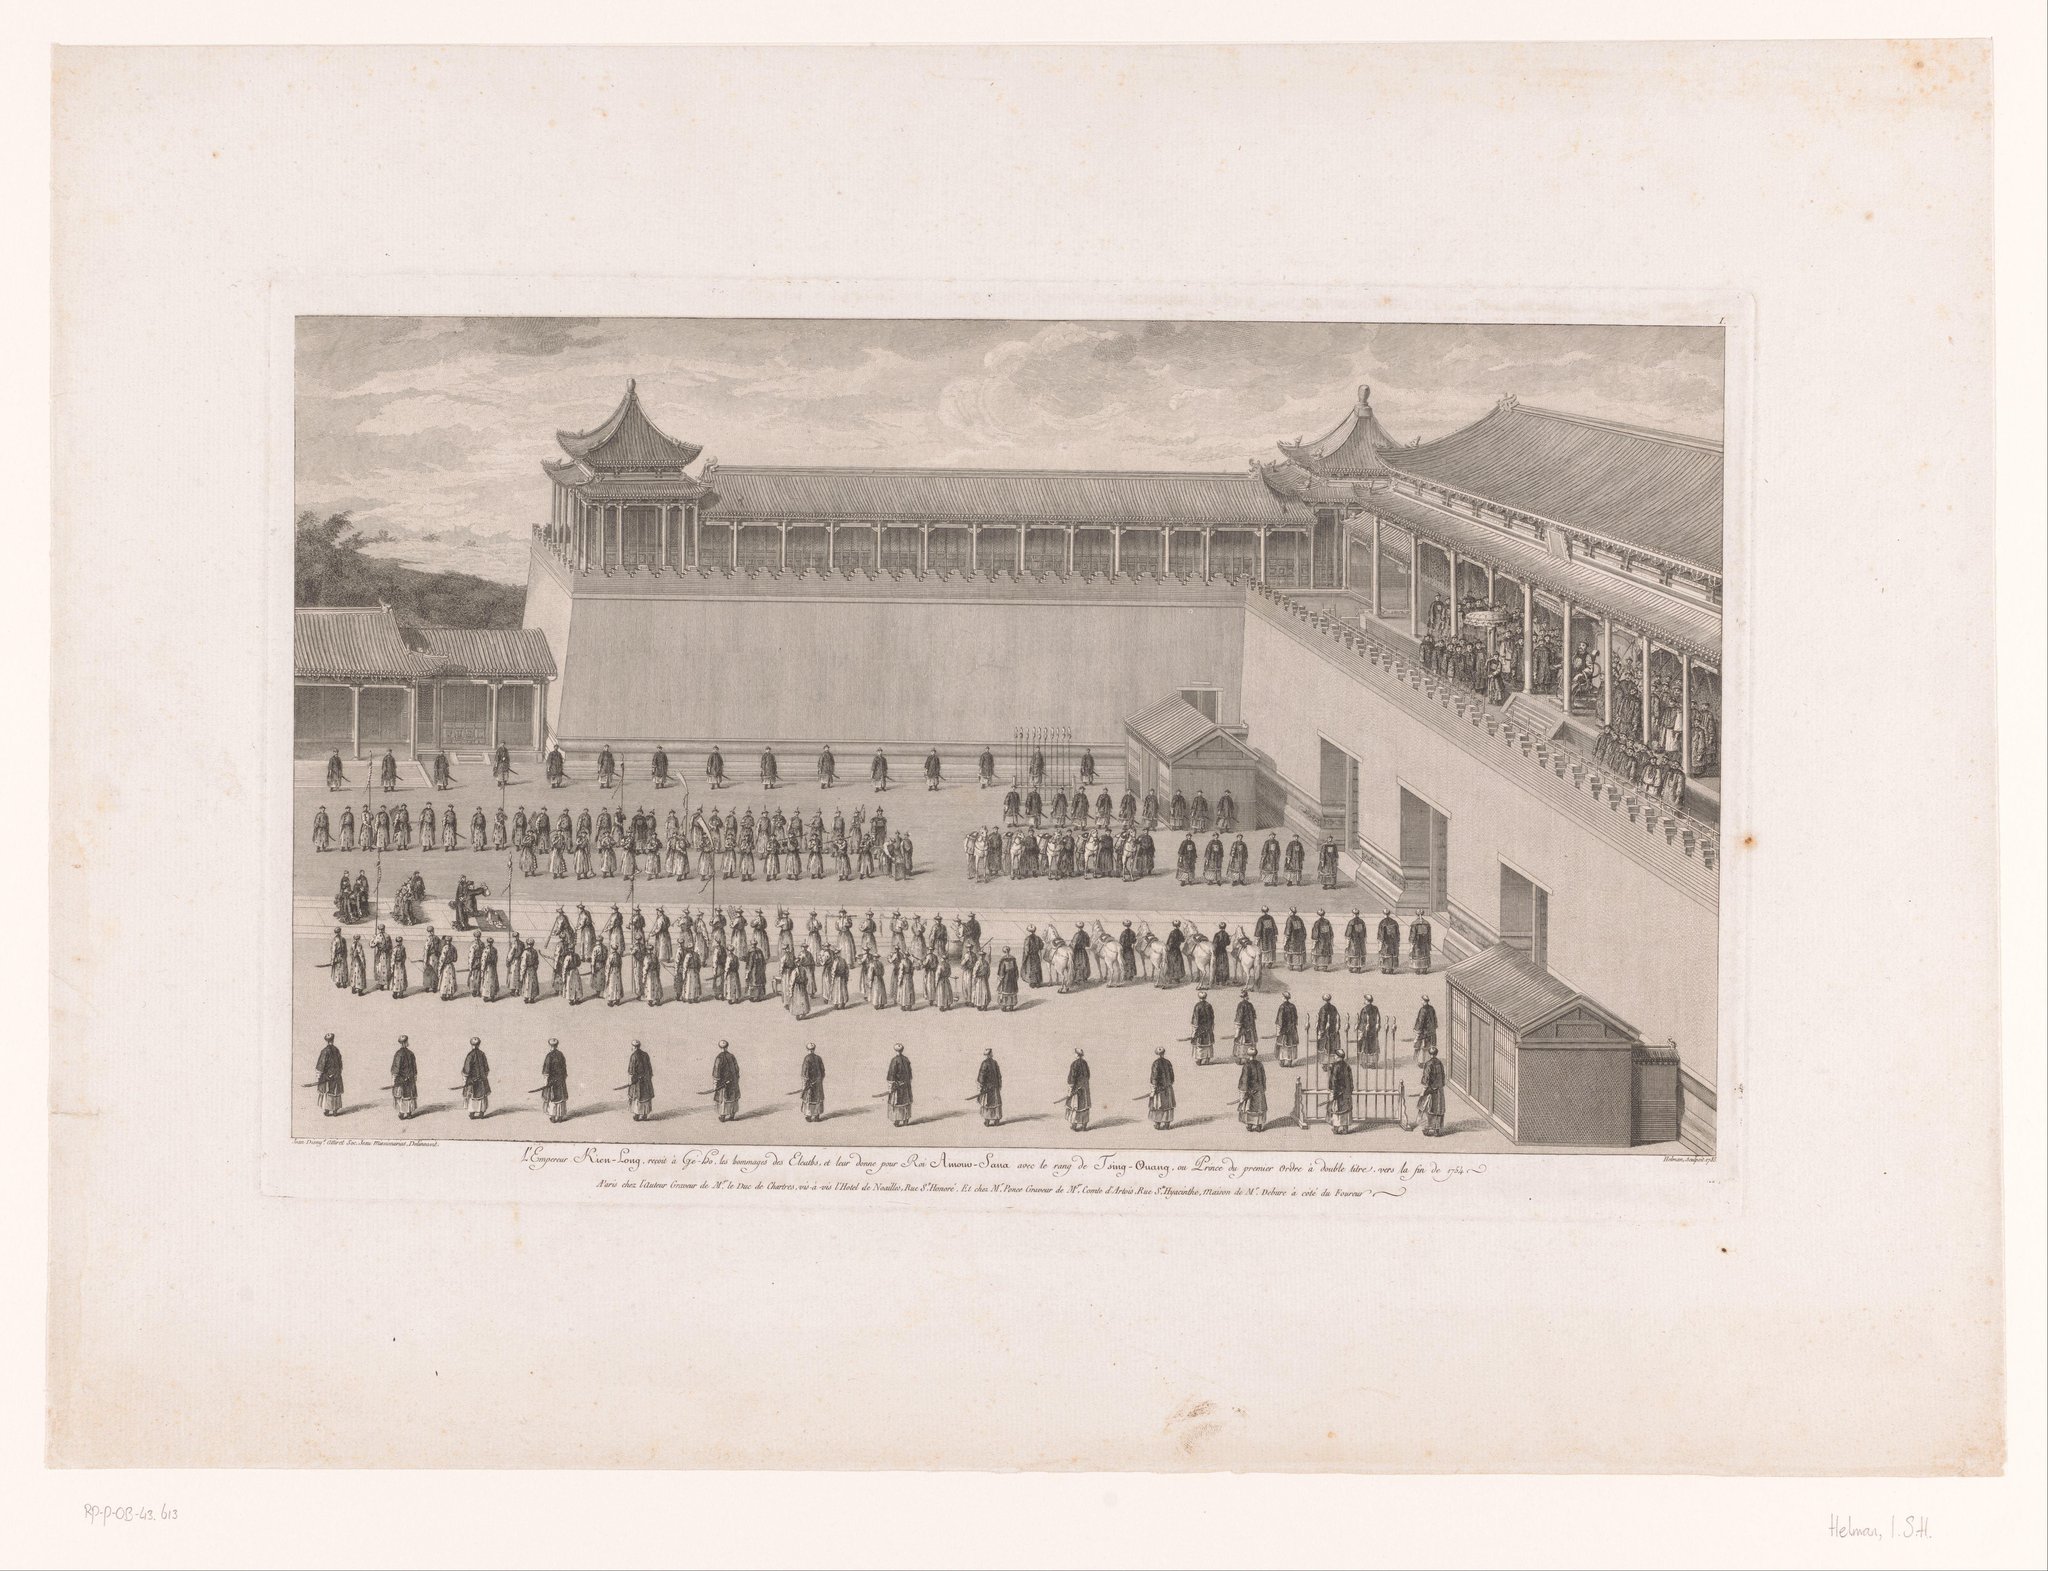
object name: print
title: Conquêtes de l'Empereur de la Chine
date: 1784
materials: paper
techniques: engraving, etching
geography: paris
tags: historical persons, prisoner of war (after the battle)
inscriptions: collector's mark: Lugt 2228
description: Prent uit een versie van de serie 'Conquêtes de l'Empereur de la Chine' met afbeeldingen van de veroveringen van keizer Qianlong van China, uitgegeven door Helman tussen 1783-1785. Voor twee bladen met bijbehorende beschrijvende tekst, zie RP-P-OB-43.629 en RP-P-OB-43.630.